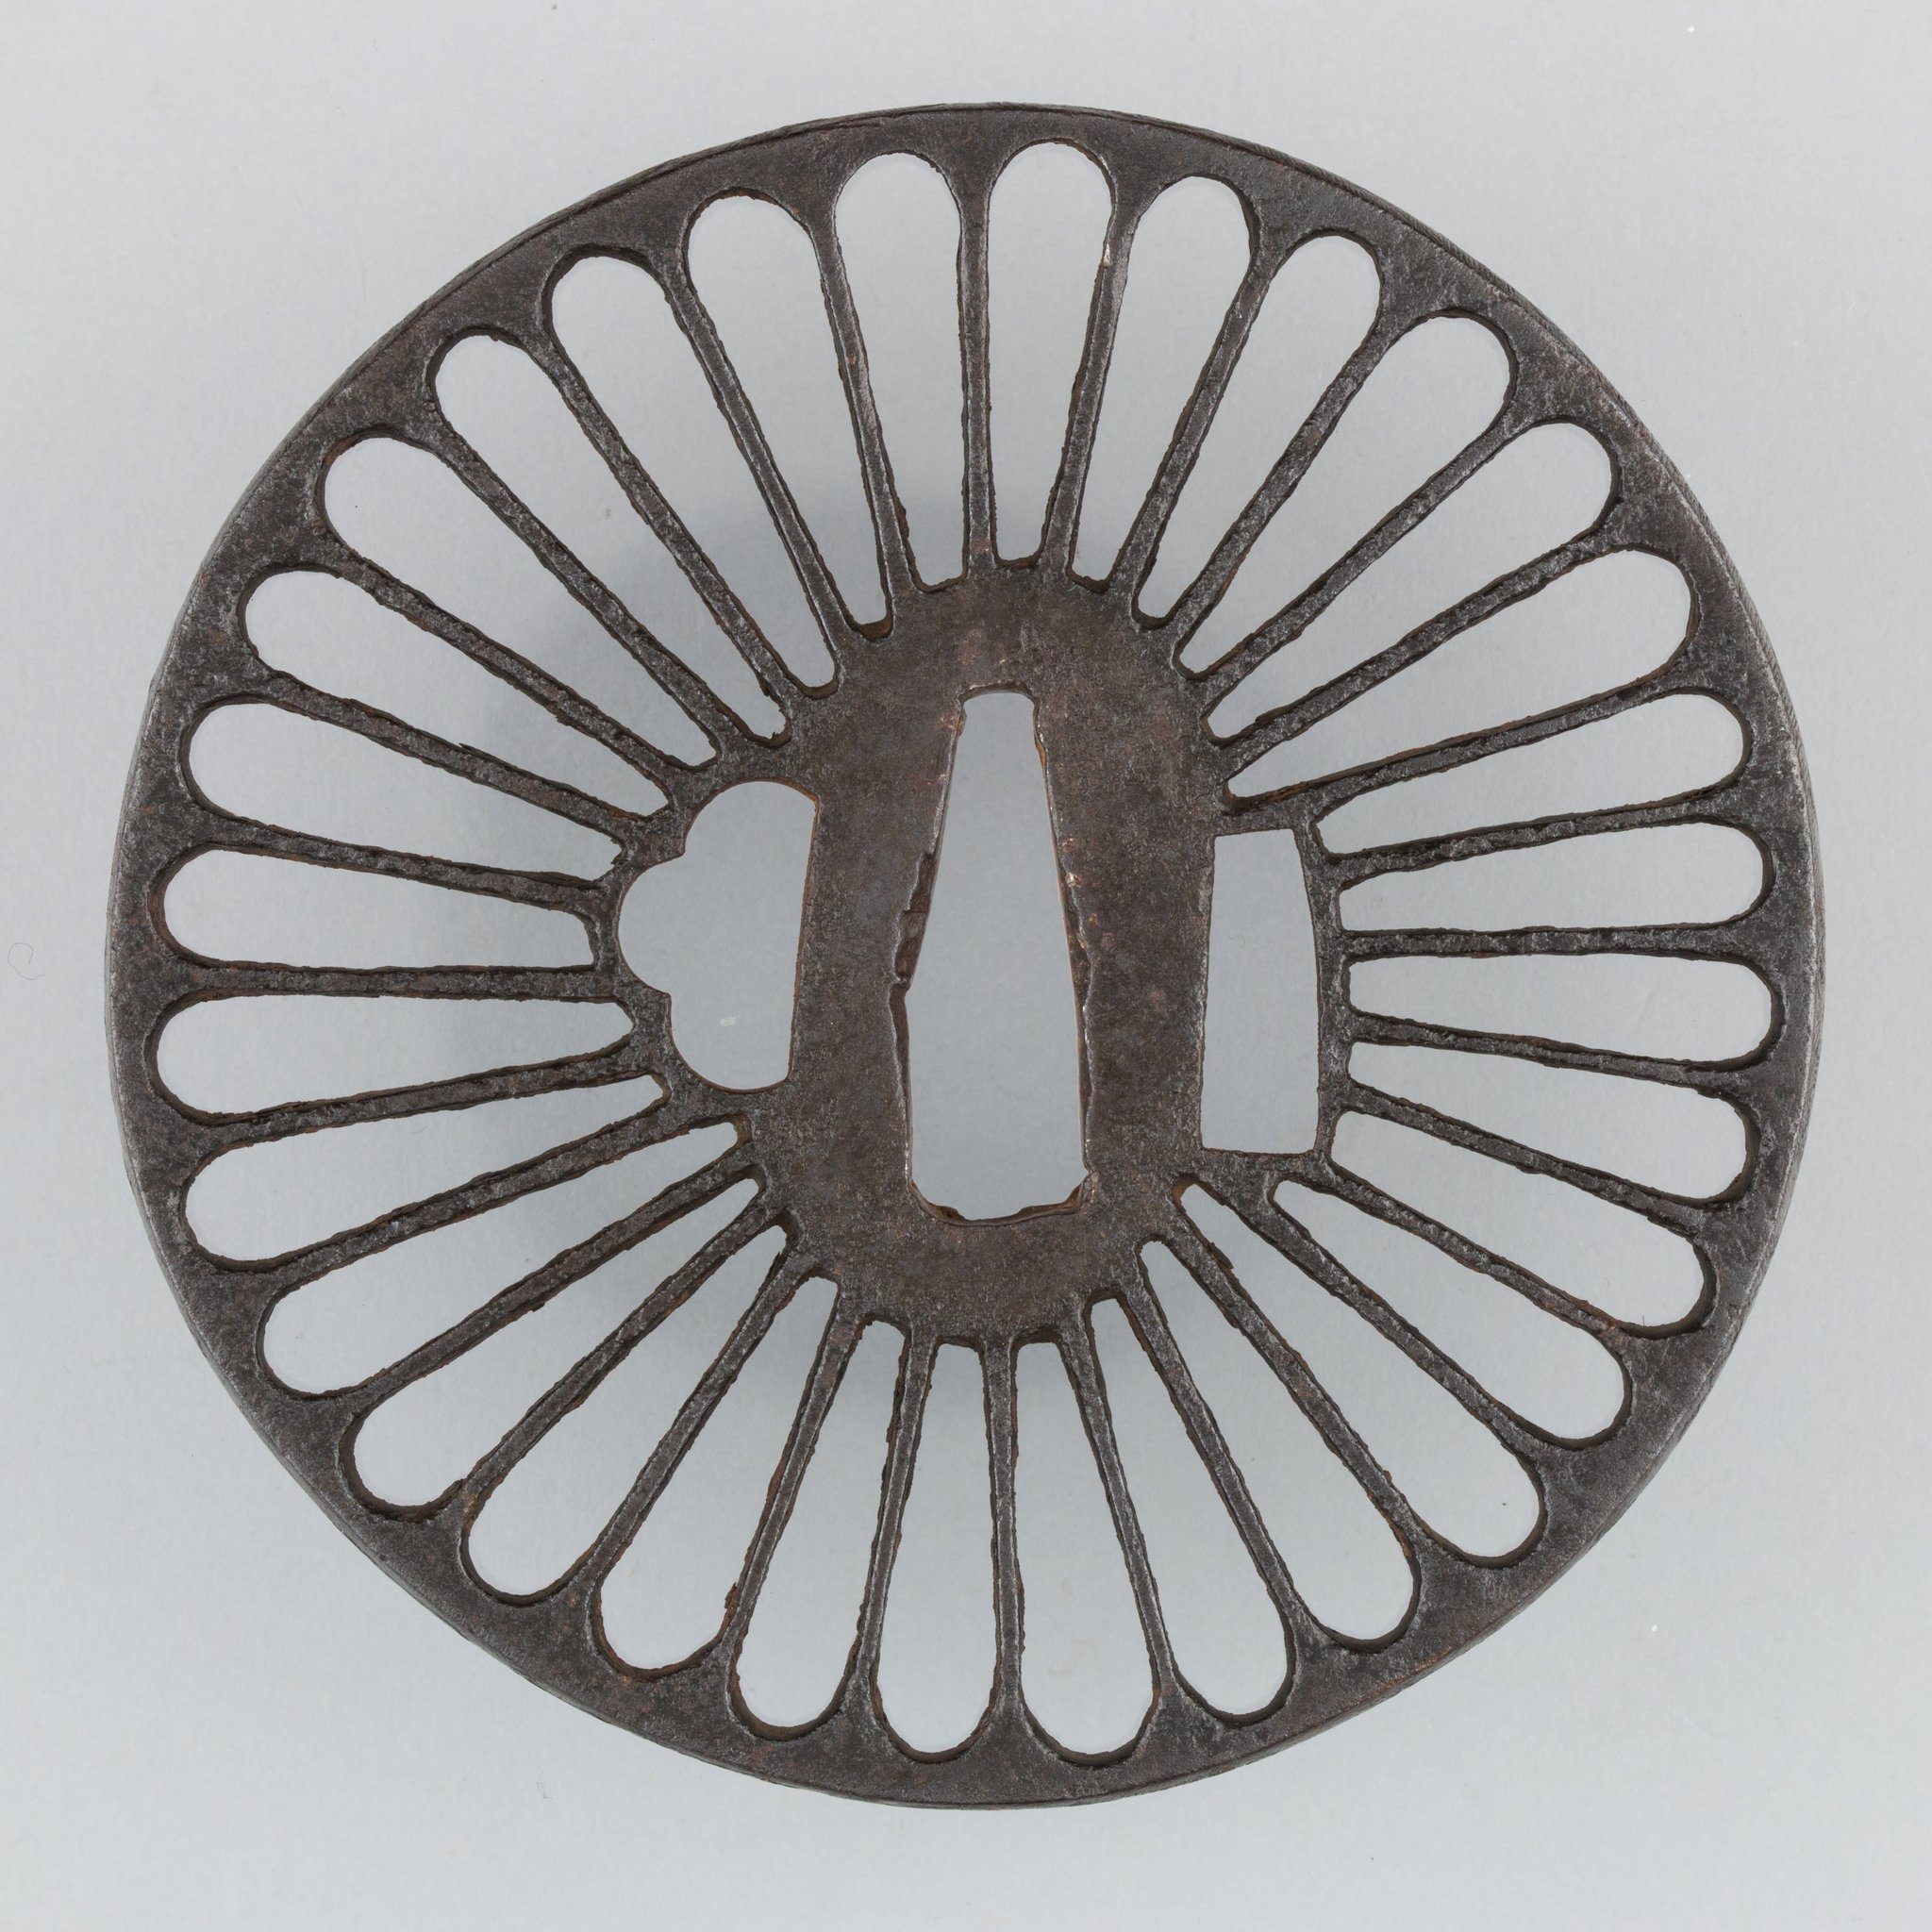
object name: sword guard tsuba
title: Sword Guard (Tsuba)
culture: japanese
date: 1501-1600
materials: copper, iron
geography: japan